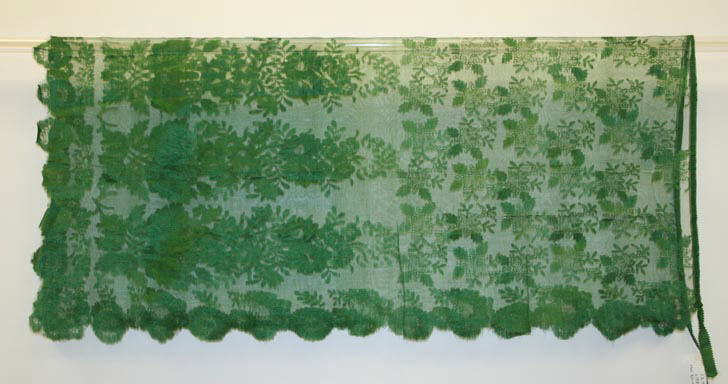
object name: veil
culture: american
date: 1855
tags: flowers